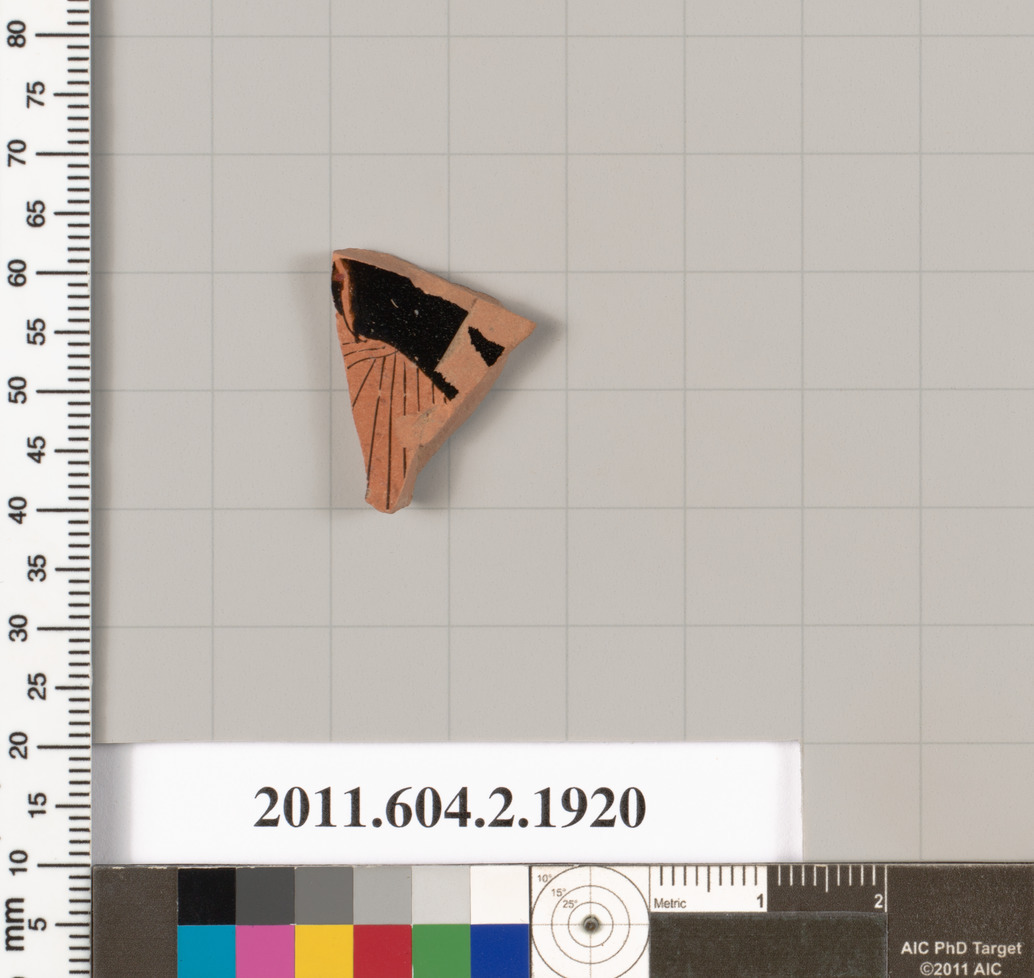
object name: skyphos fragment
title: Terracotta fragment of a skyphos (deep drinking cup)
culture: greek, attic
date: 450-426 BCE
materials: terracotta